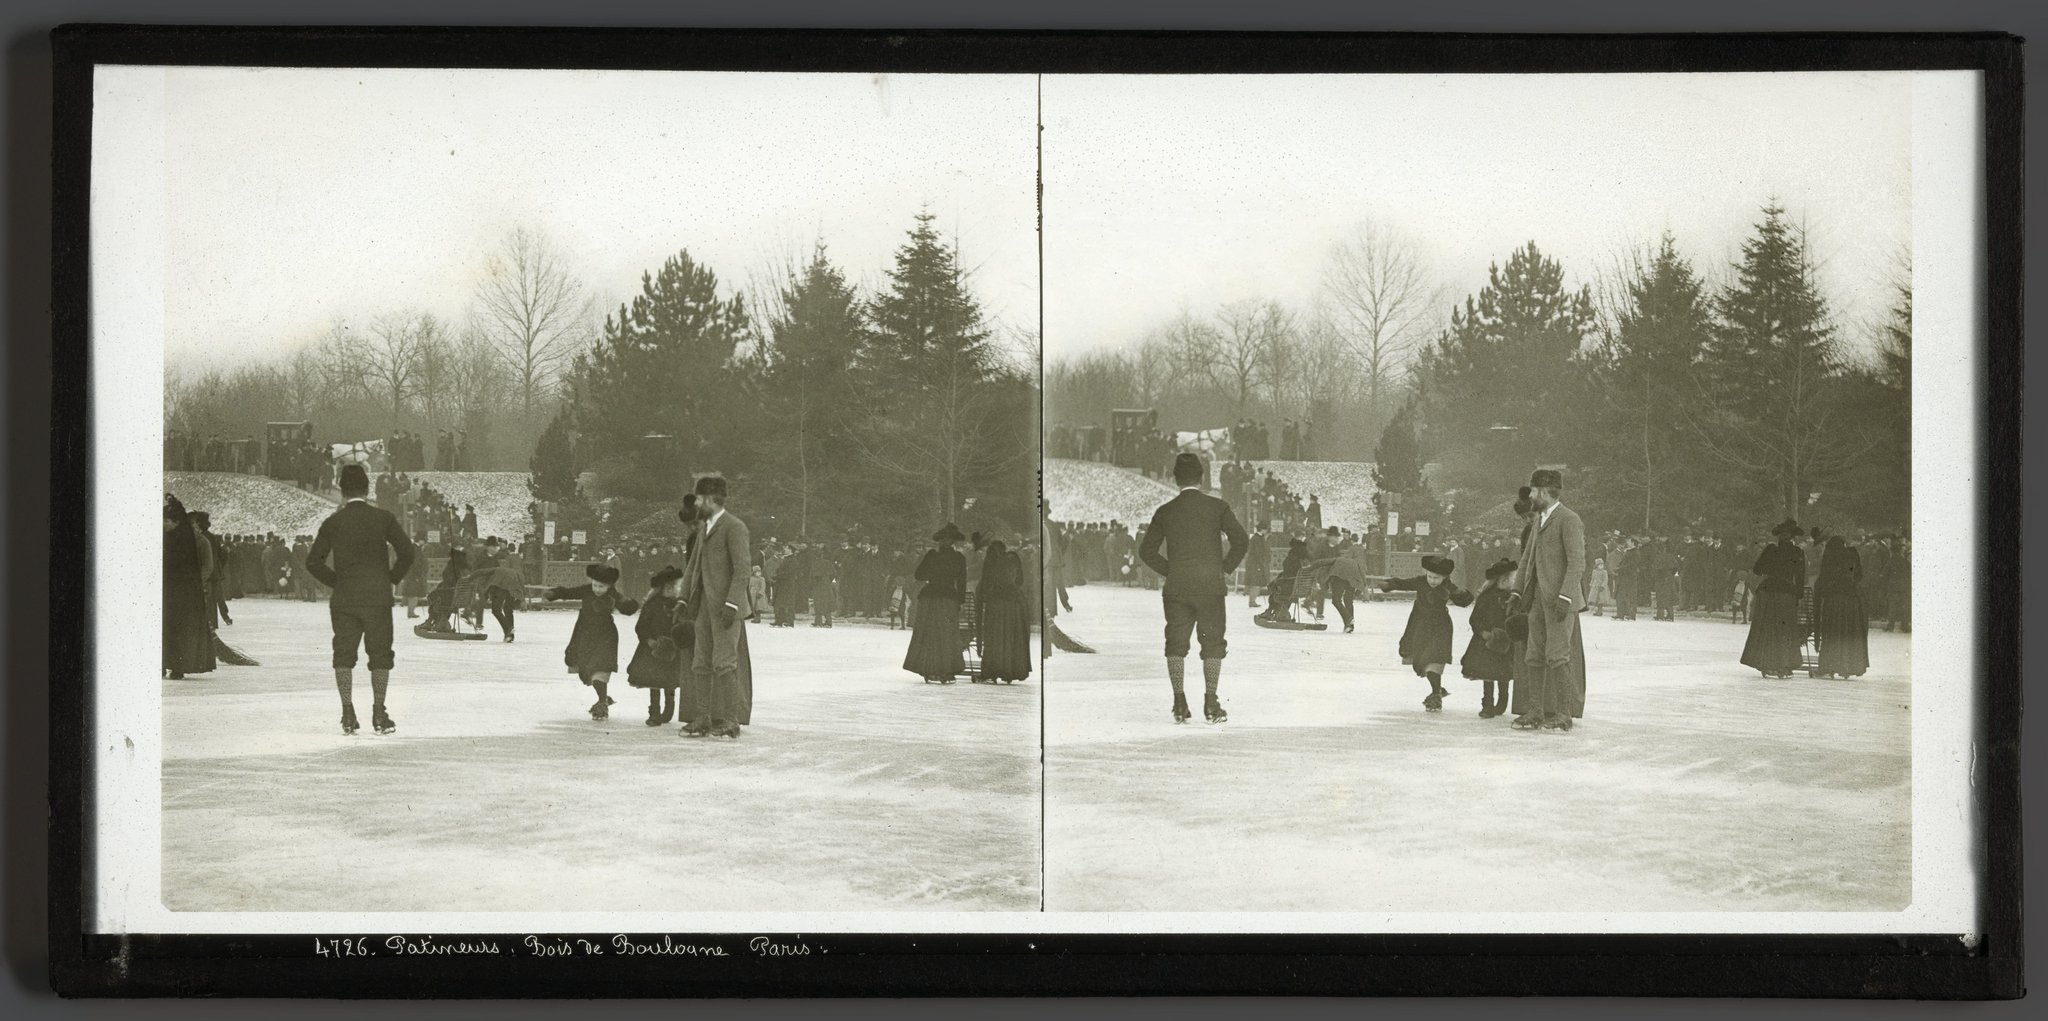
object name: stereoscopic photograph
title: Patineurs, Bois de Boulogne, Paris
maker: Anonymous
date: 1860-1890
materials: glass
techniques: slide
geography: bois de boulogne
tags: skates (winter sports)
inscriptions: number: ‘4726.’